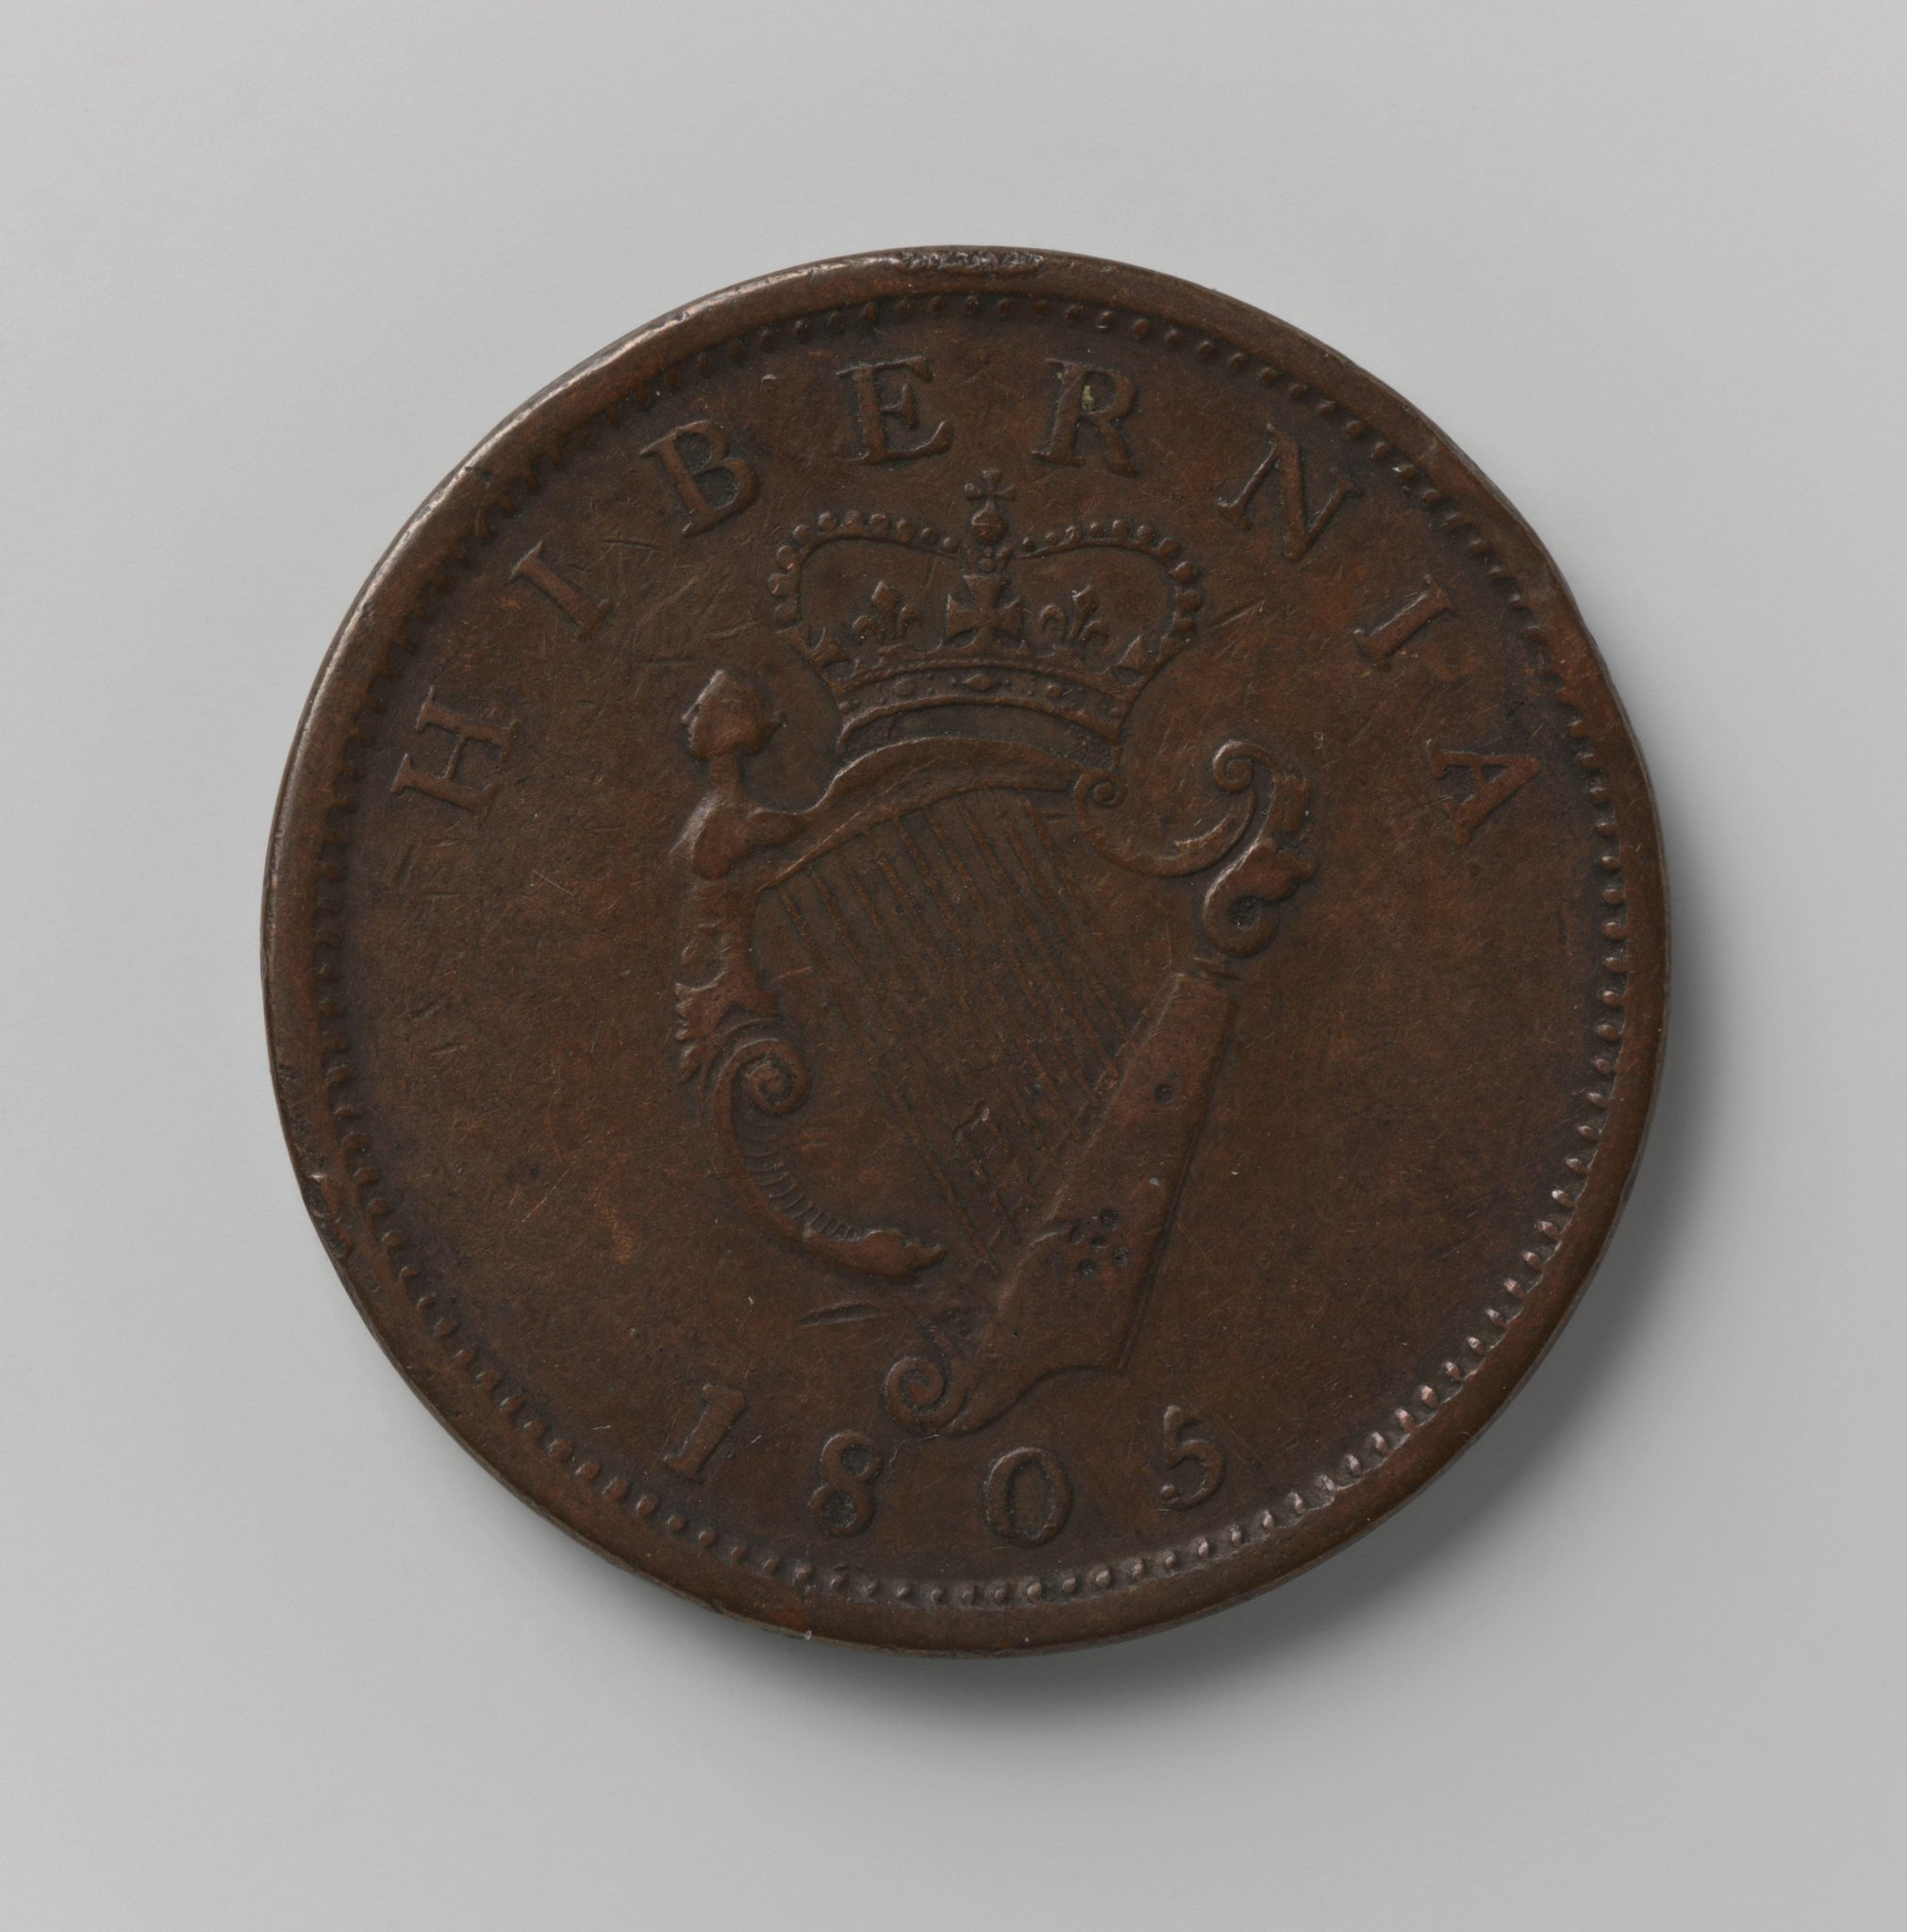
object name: coin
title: Penny uit Ierland van George III, 1805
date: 1805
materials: copper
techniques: striking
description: Koperen munt. Voorzijde: gelauwerd hoofd van de vorst naar rechts. Keerzijde: gekroonde harp. Jaartal onderaan. Kabelrand.